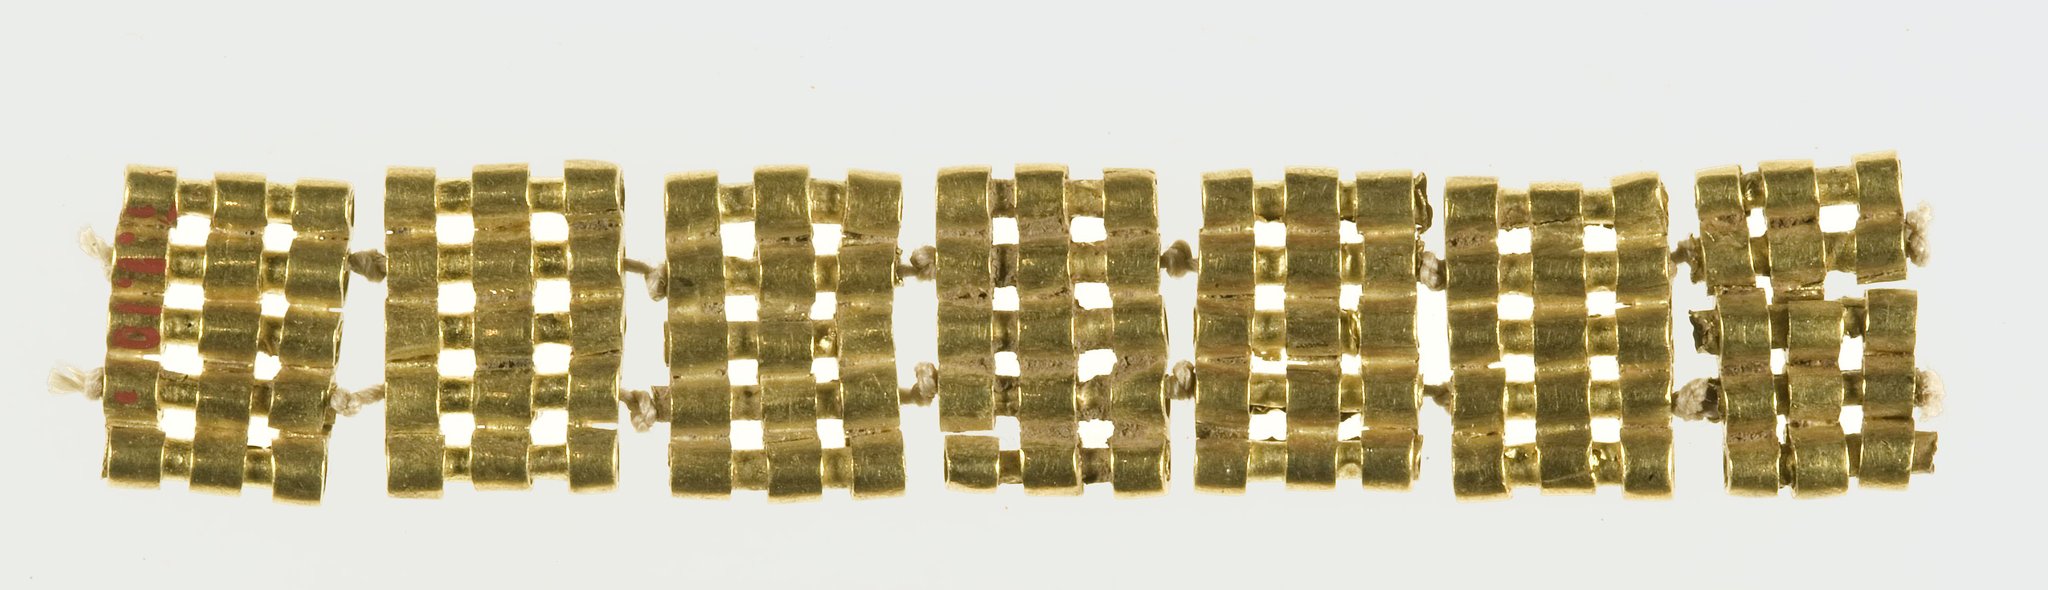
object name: spacer, sithathoryunet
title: Unattached Spacers from a Bracelet or Anklet of Sithathoryunet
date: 1887-1813 BCE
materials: gold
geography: egypt